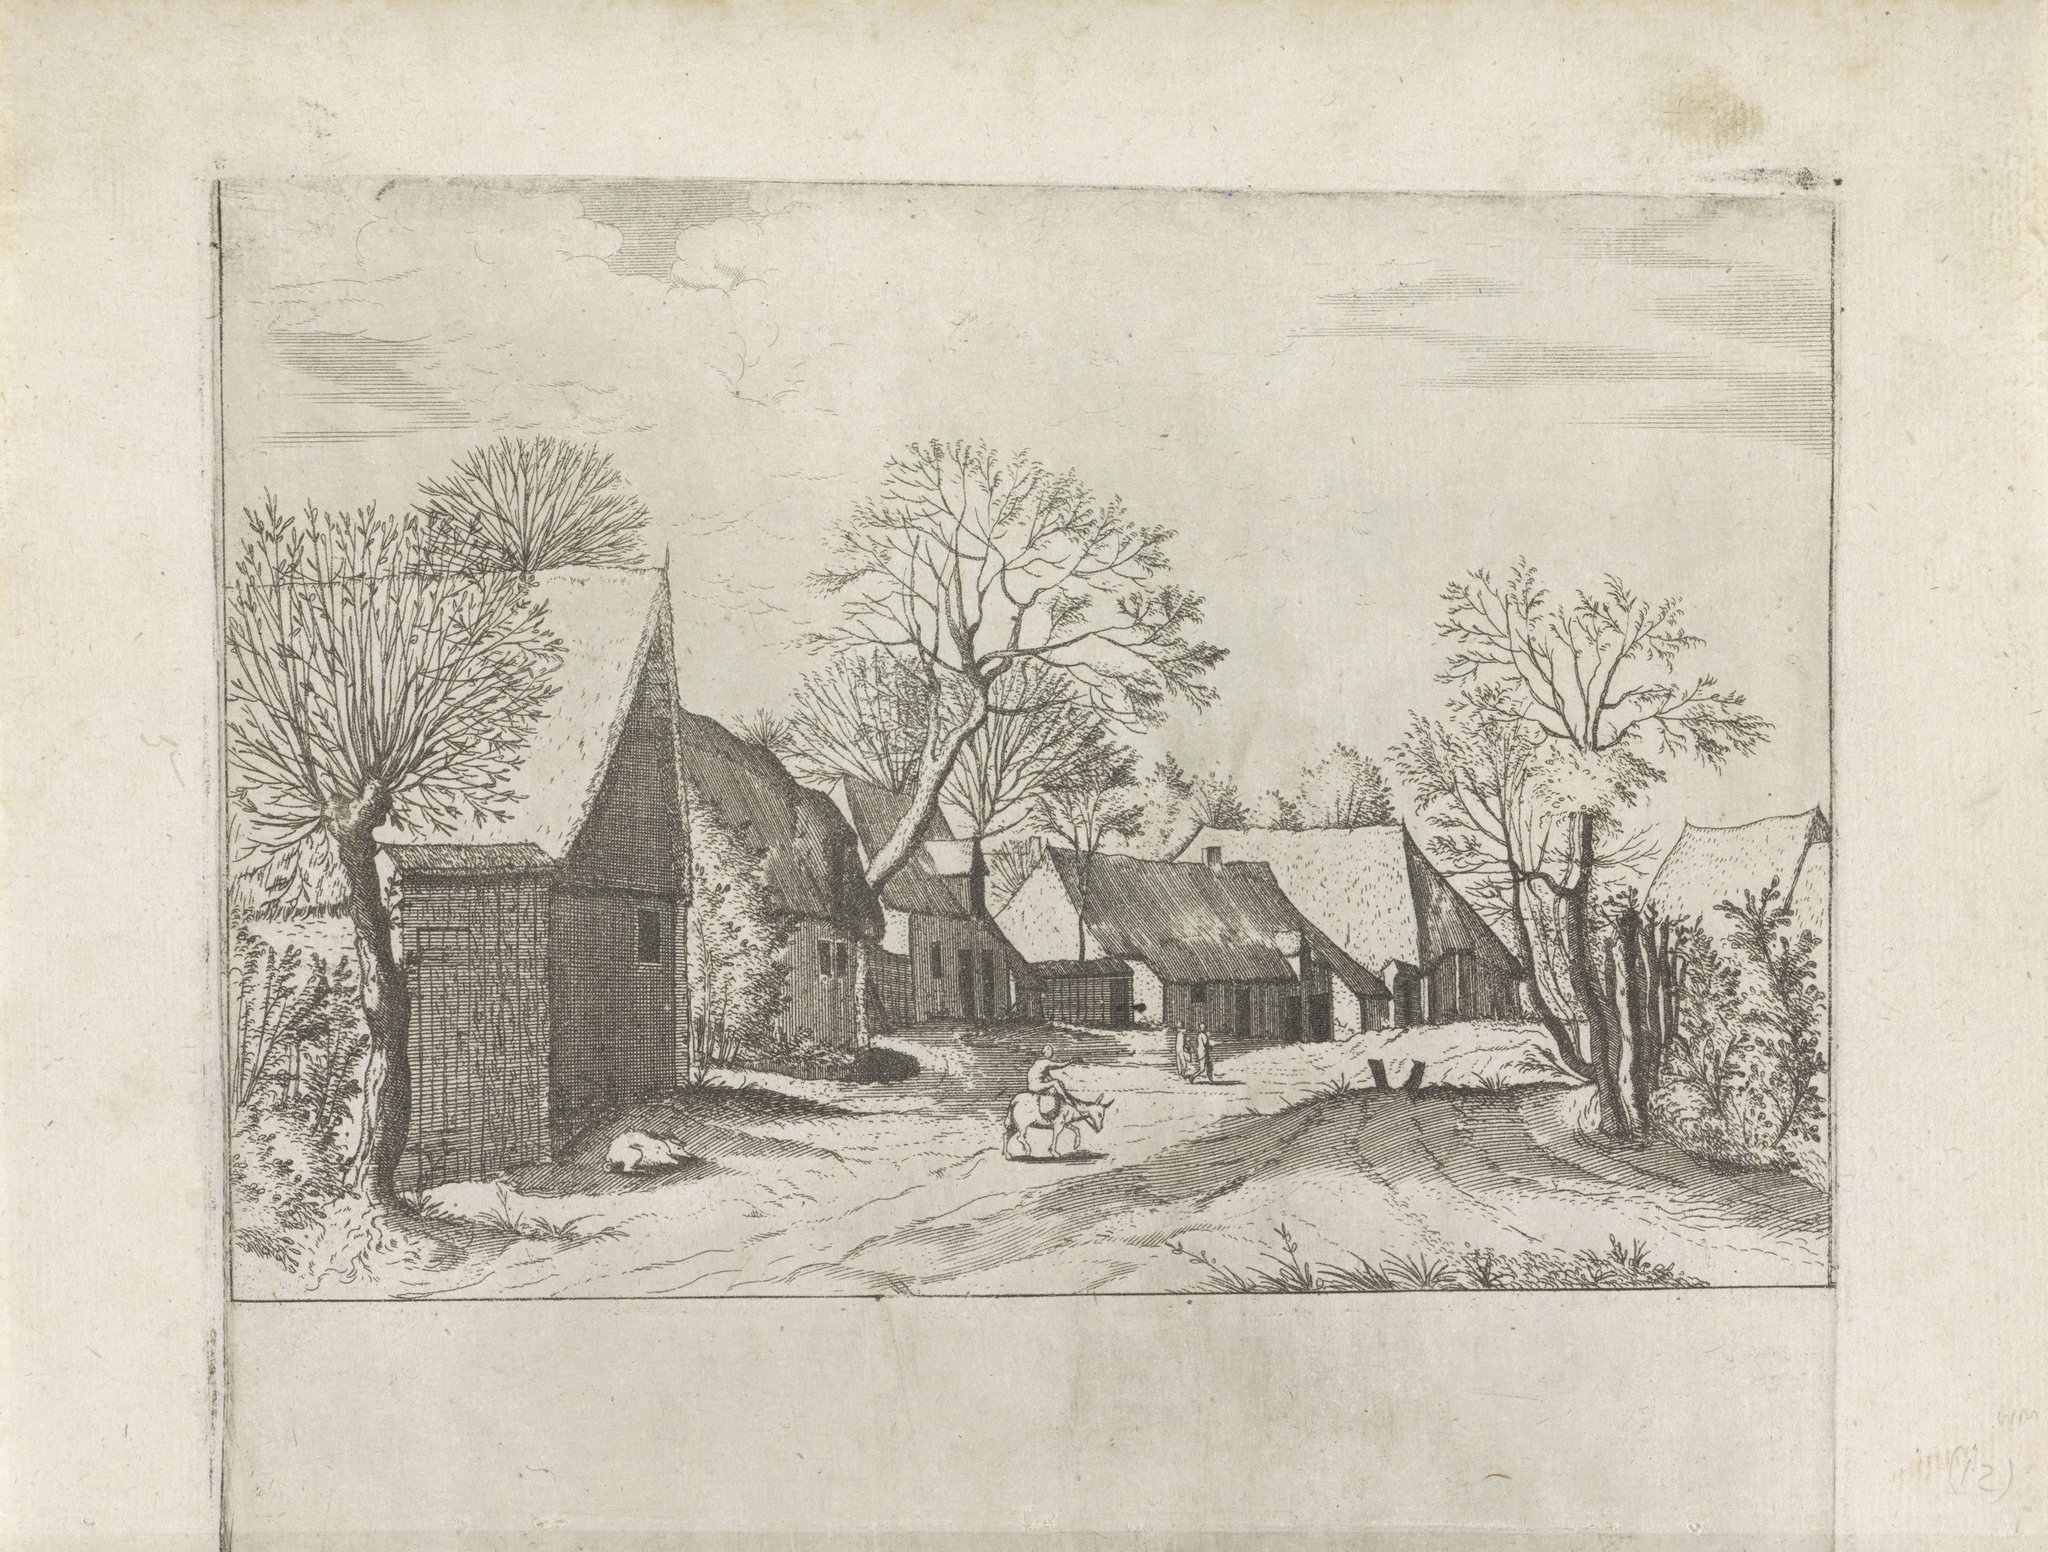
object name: print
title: Kleine landschappen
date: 1559-1561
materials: paper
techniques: etching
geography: antwerp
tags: ass, donkey, village, farm (building)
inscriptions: collector's mark: Lugt 2228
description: Landschap met boerderijen en een schuur langs een weg. Op de voorgrond rijdt een man op een ezel.